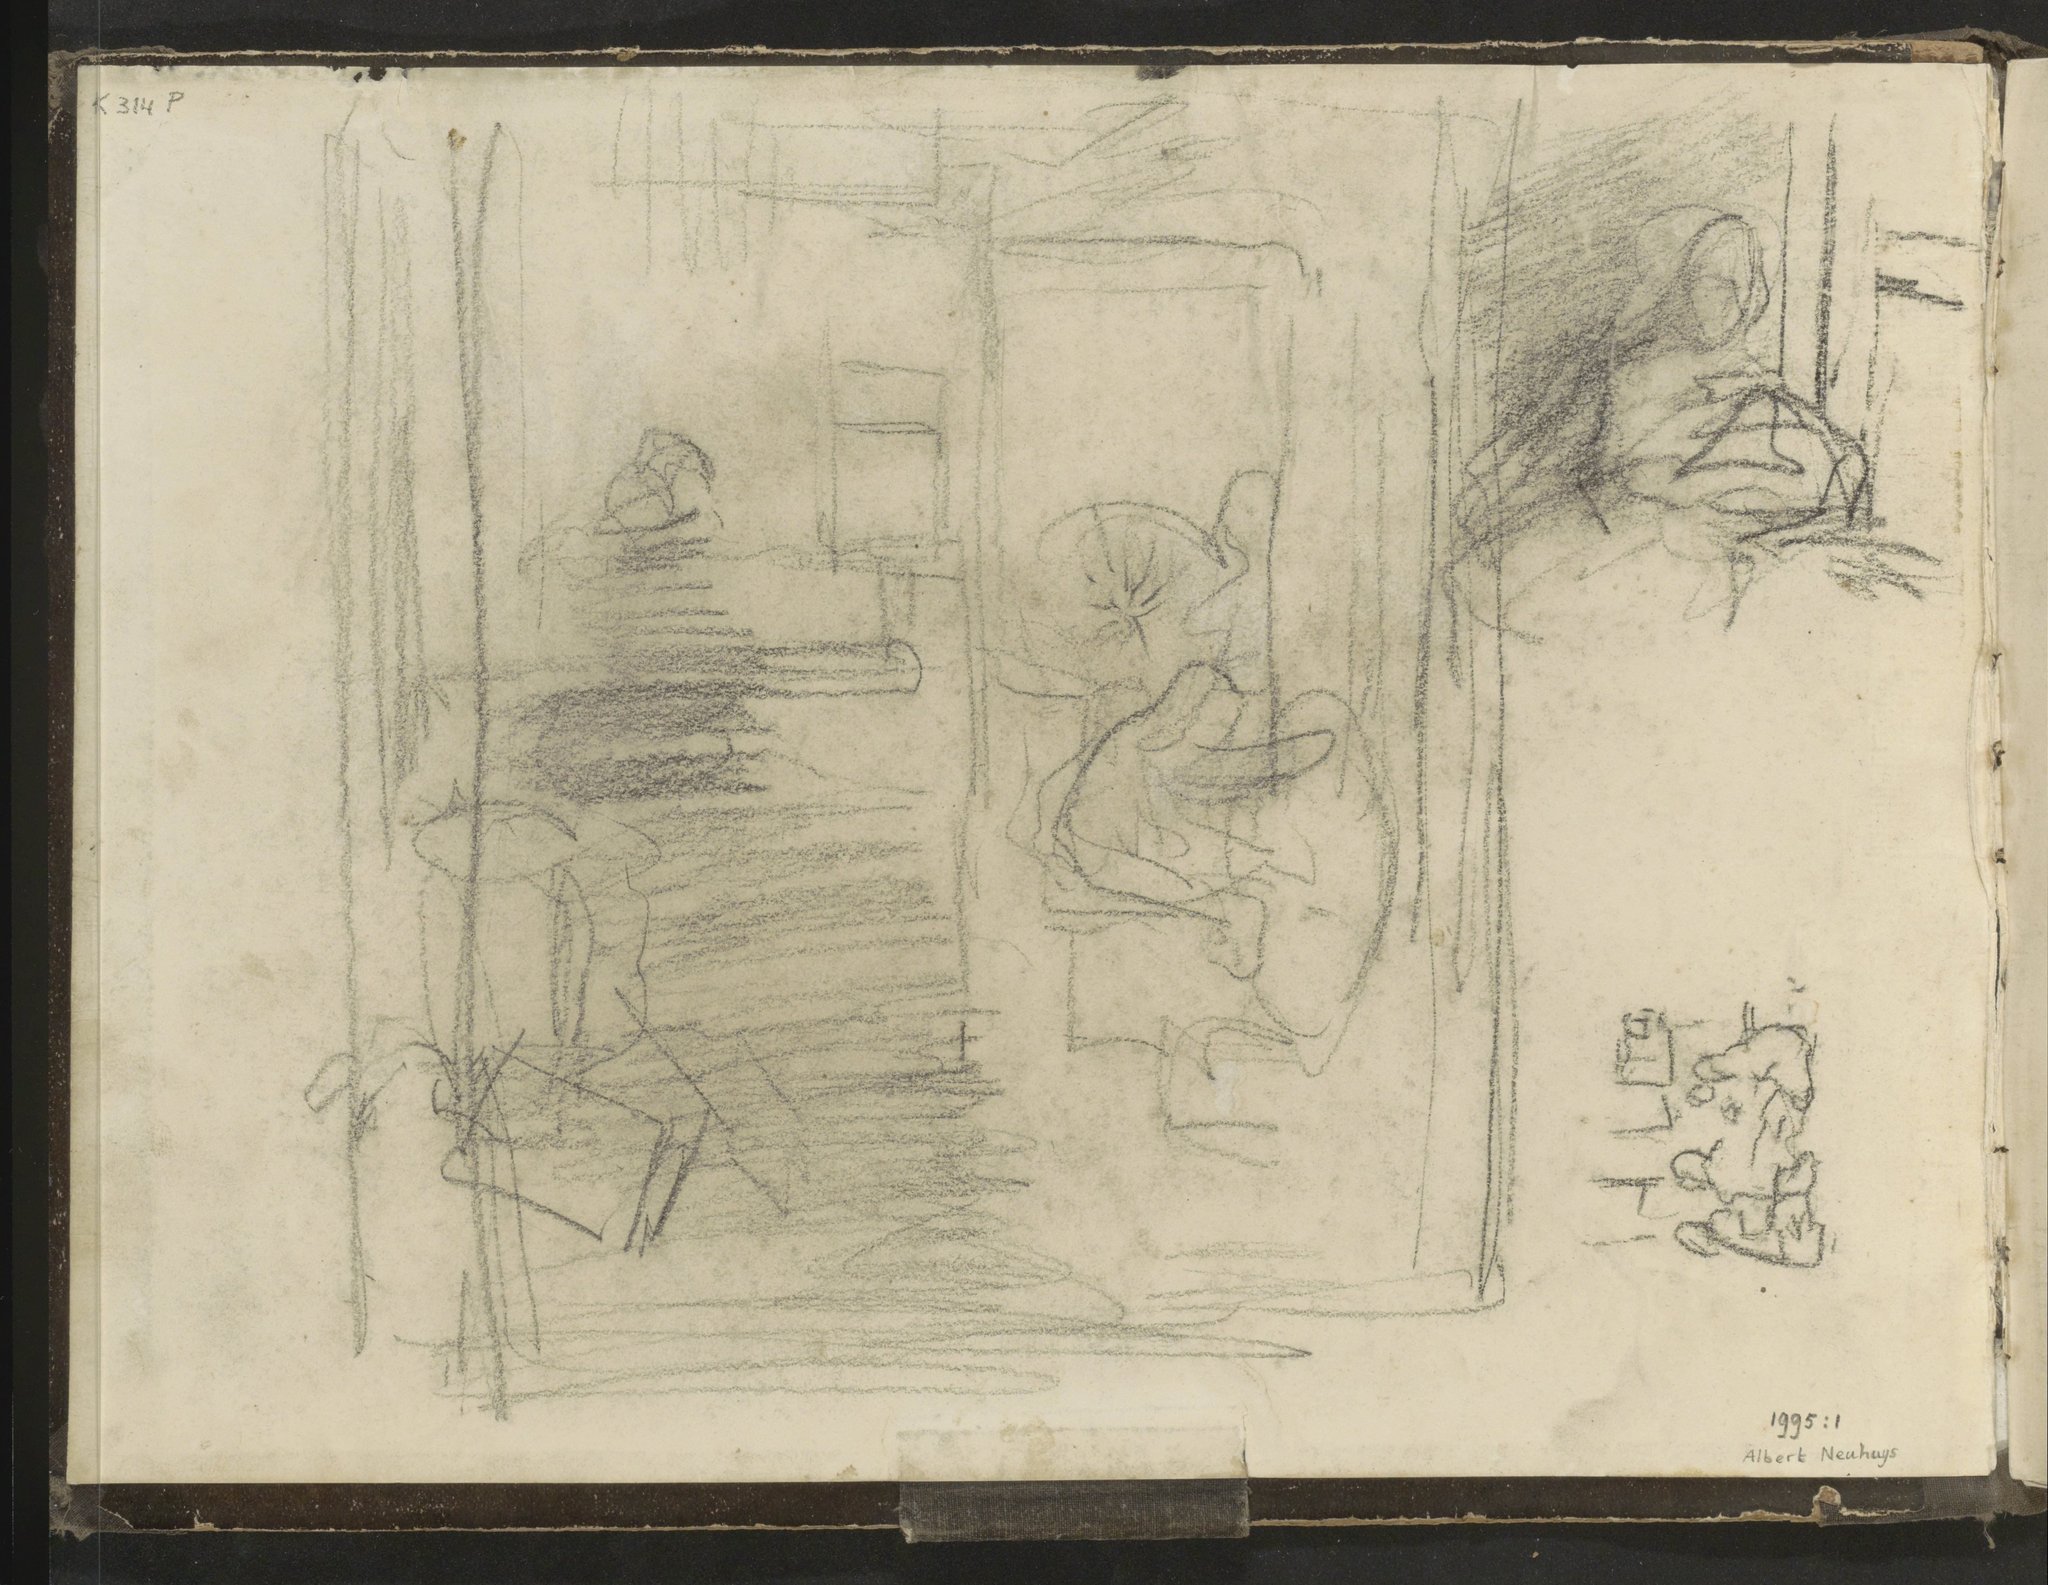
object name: sketchbook leaf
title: Interieurs met figuren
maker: albert neuhuys (1844-1914)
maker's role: draughtsman, painter, print maker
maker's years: 1844-1914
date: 1854-1914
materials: chalk, paper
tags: anatomy (non-medical), interior of the house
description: Voorste schutblad uit een schetsboek met 43 bladen.